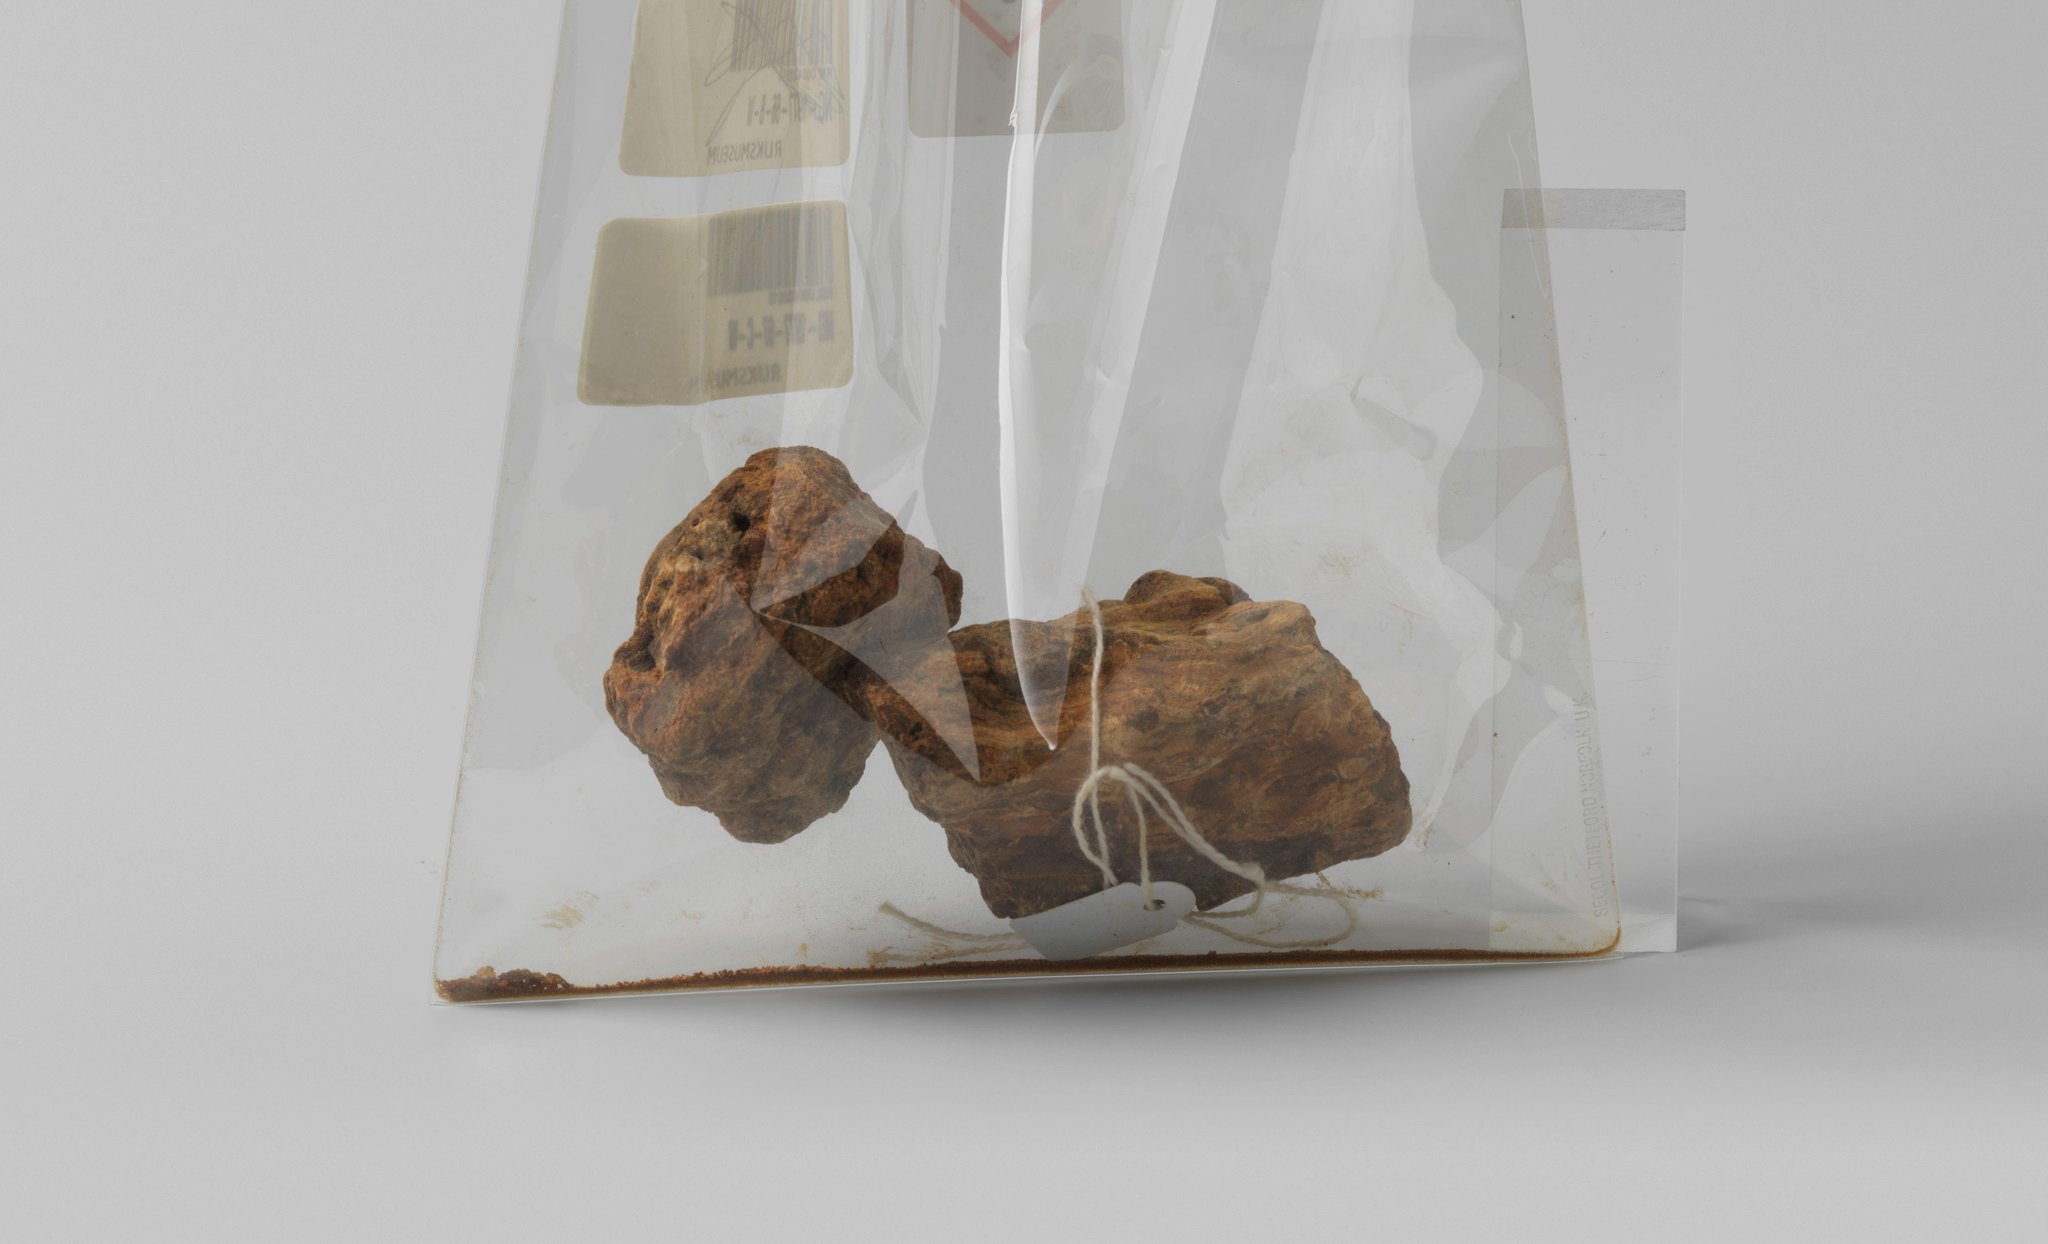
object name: artifact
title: Brok uit V.O.C.-schip de 'Witte Leeuw'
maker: Anonymous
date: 1613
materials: pigment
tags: verenigde oostindische compagnie, sint-helena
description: Brok uit V.O.C.-schip de 'Witte Leeuw', loodwit, grondstof voor verf.